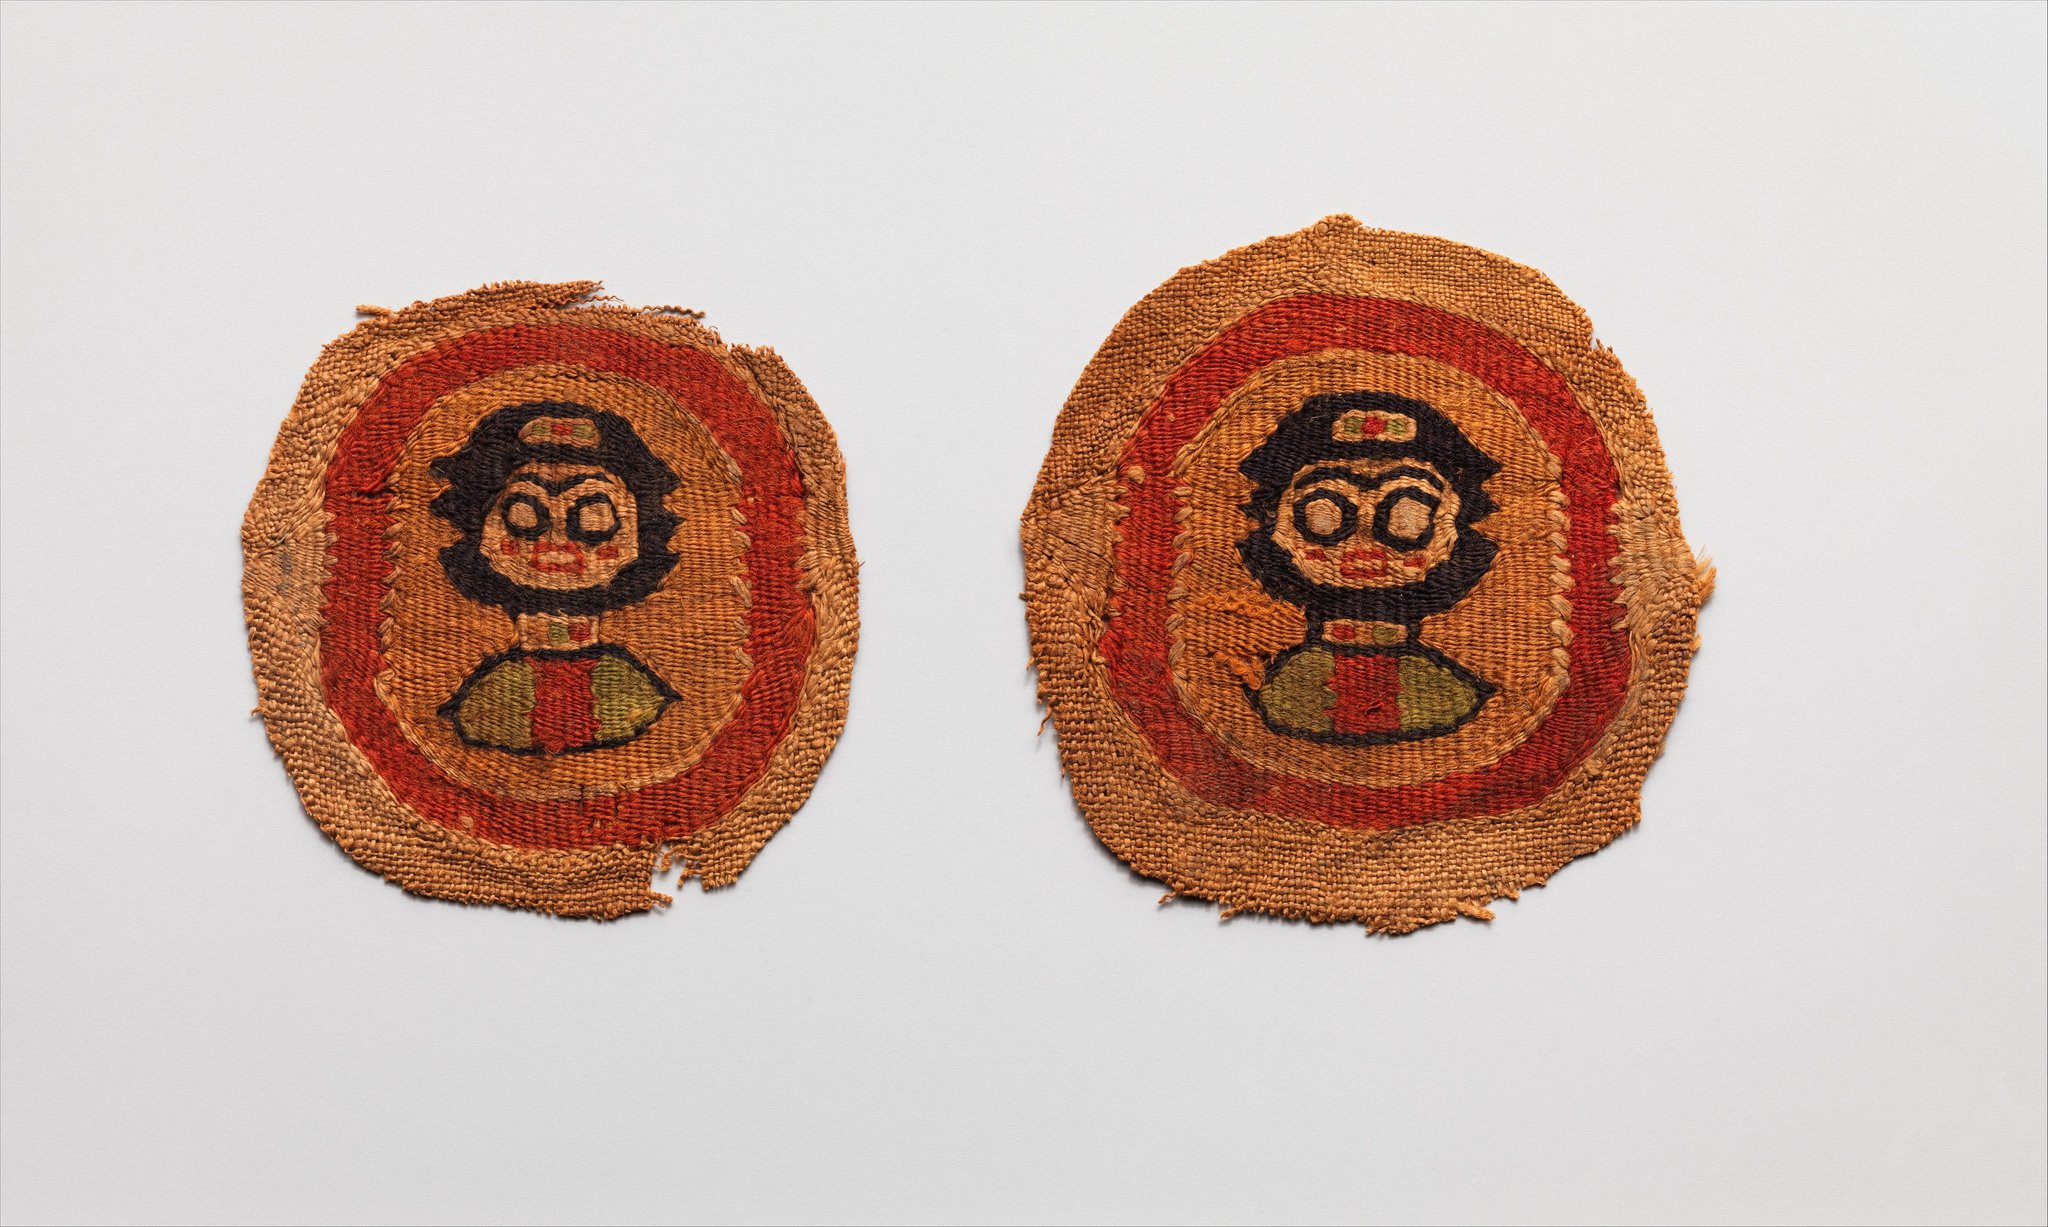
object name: textile fragment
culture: coptic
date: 501-600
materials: linen, wool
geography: egypt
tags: human figures